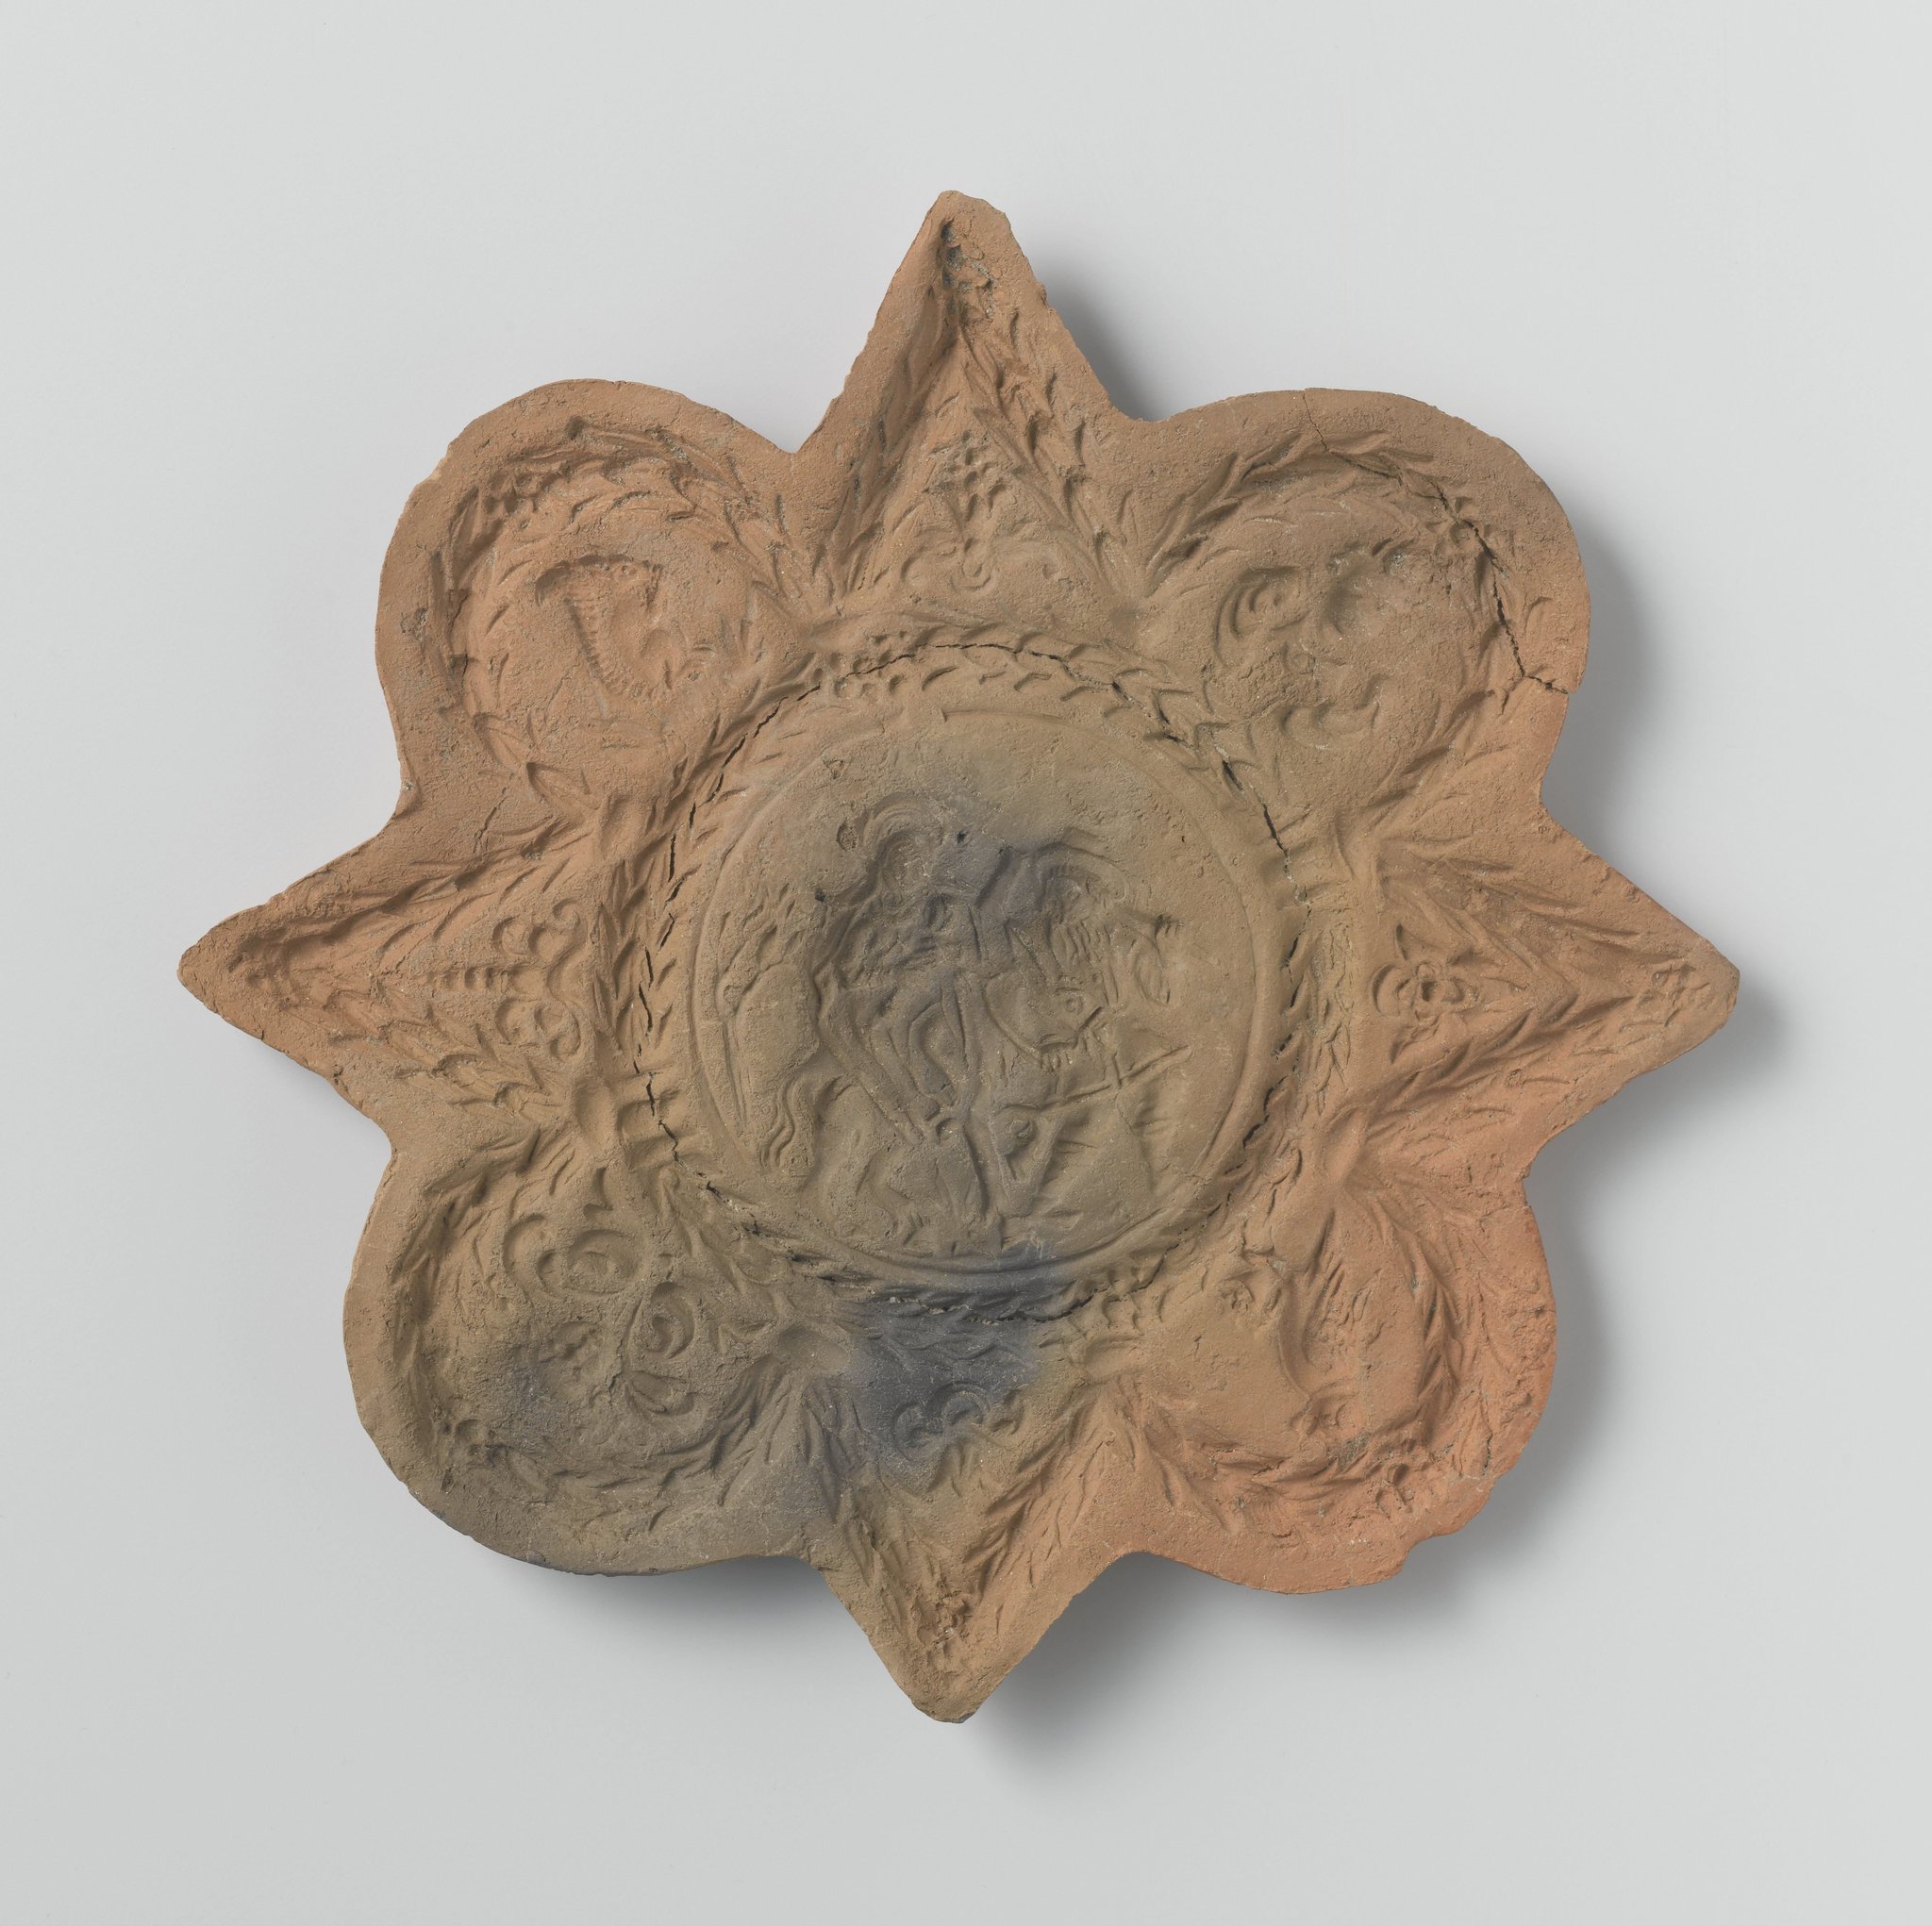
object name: mould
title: The Baptism in the river Jordan (mould with original impression)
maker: Anonymous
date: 1550-1600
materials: clay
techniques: firing, forming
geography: leiden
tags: leiden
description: In the Middle Ages many cheap, simple religious items were produced, such as this terracotta pax. The mould was created directly from the costly ivory pax adjacent. While the scene of the baptism of Christ is an exact copy, the heraldic shield is omitted. This group of three objects shows how luxury works of art inspired cheap serial products.